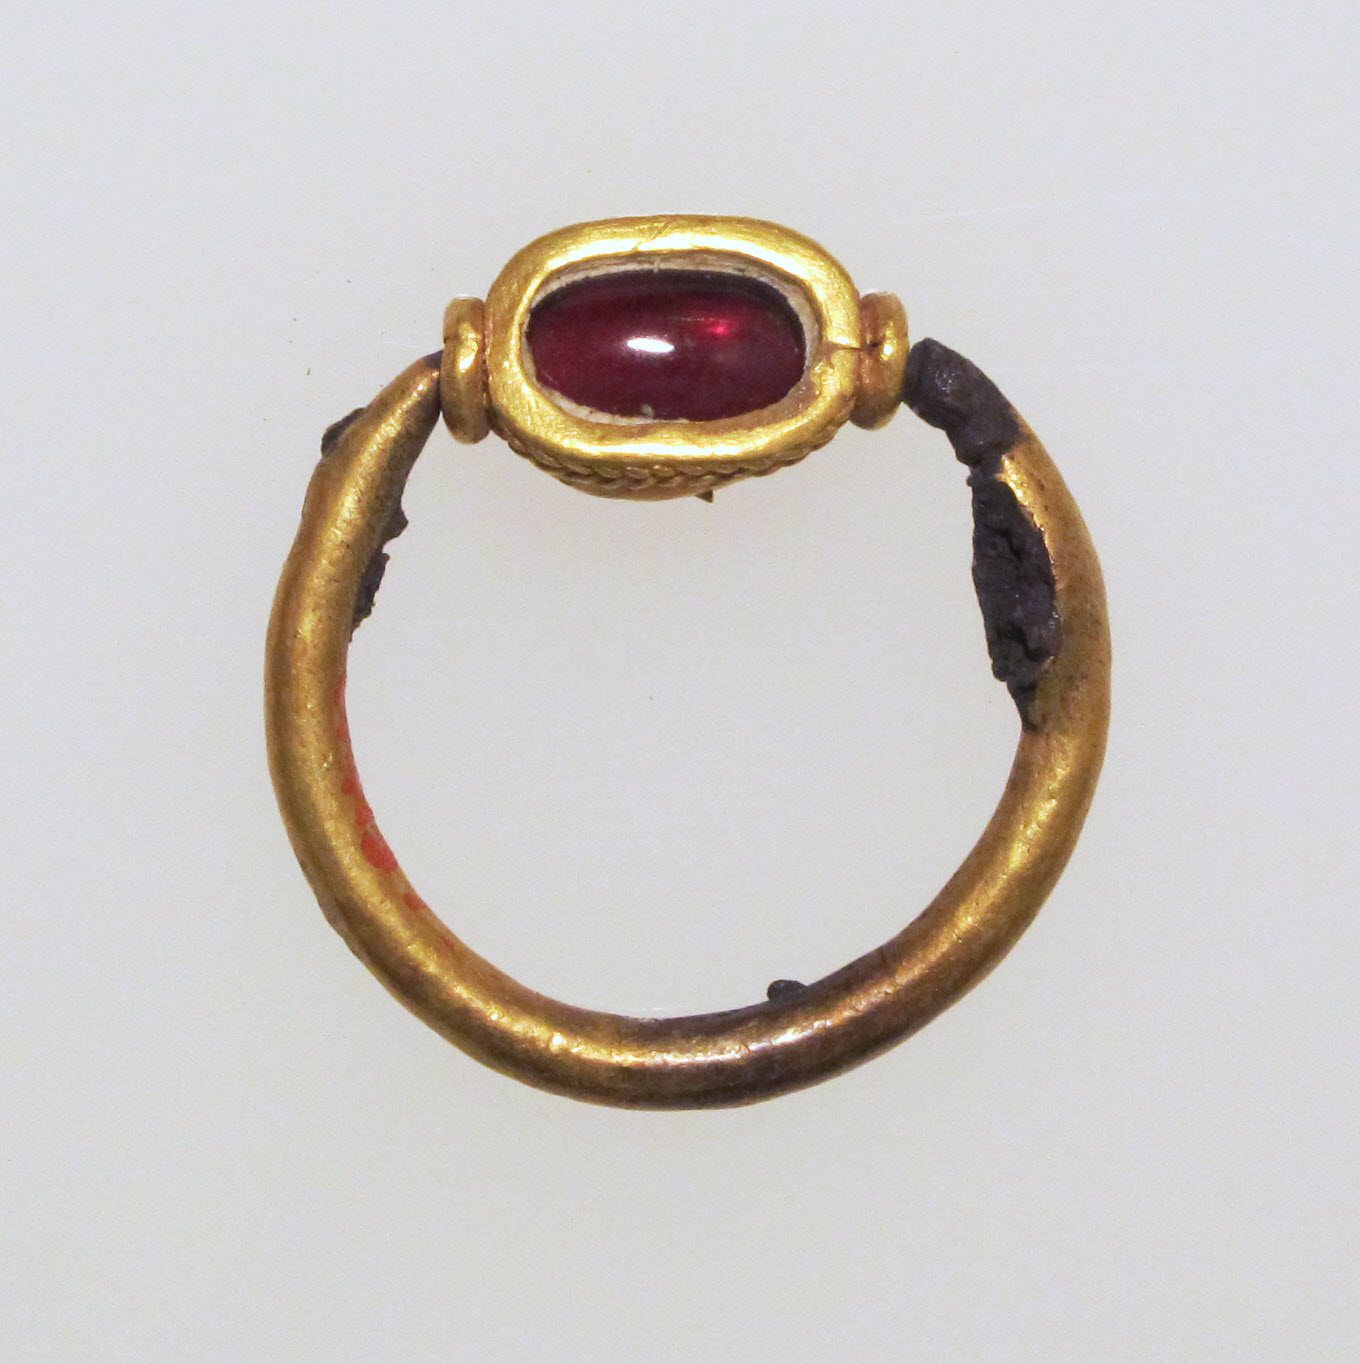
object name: ring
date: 7000 BCE-330 CE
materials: gemstone, gold, silver